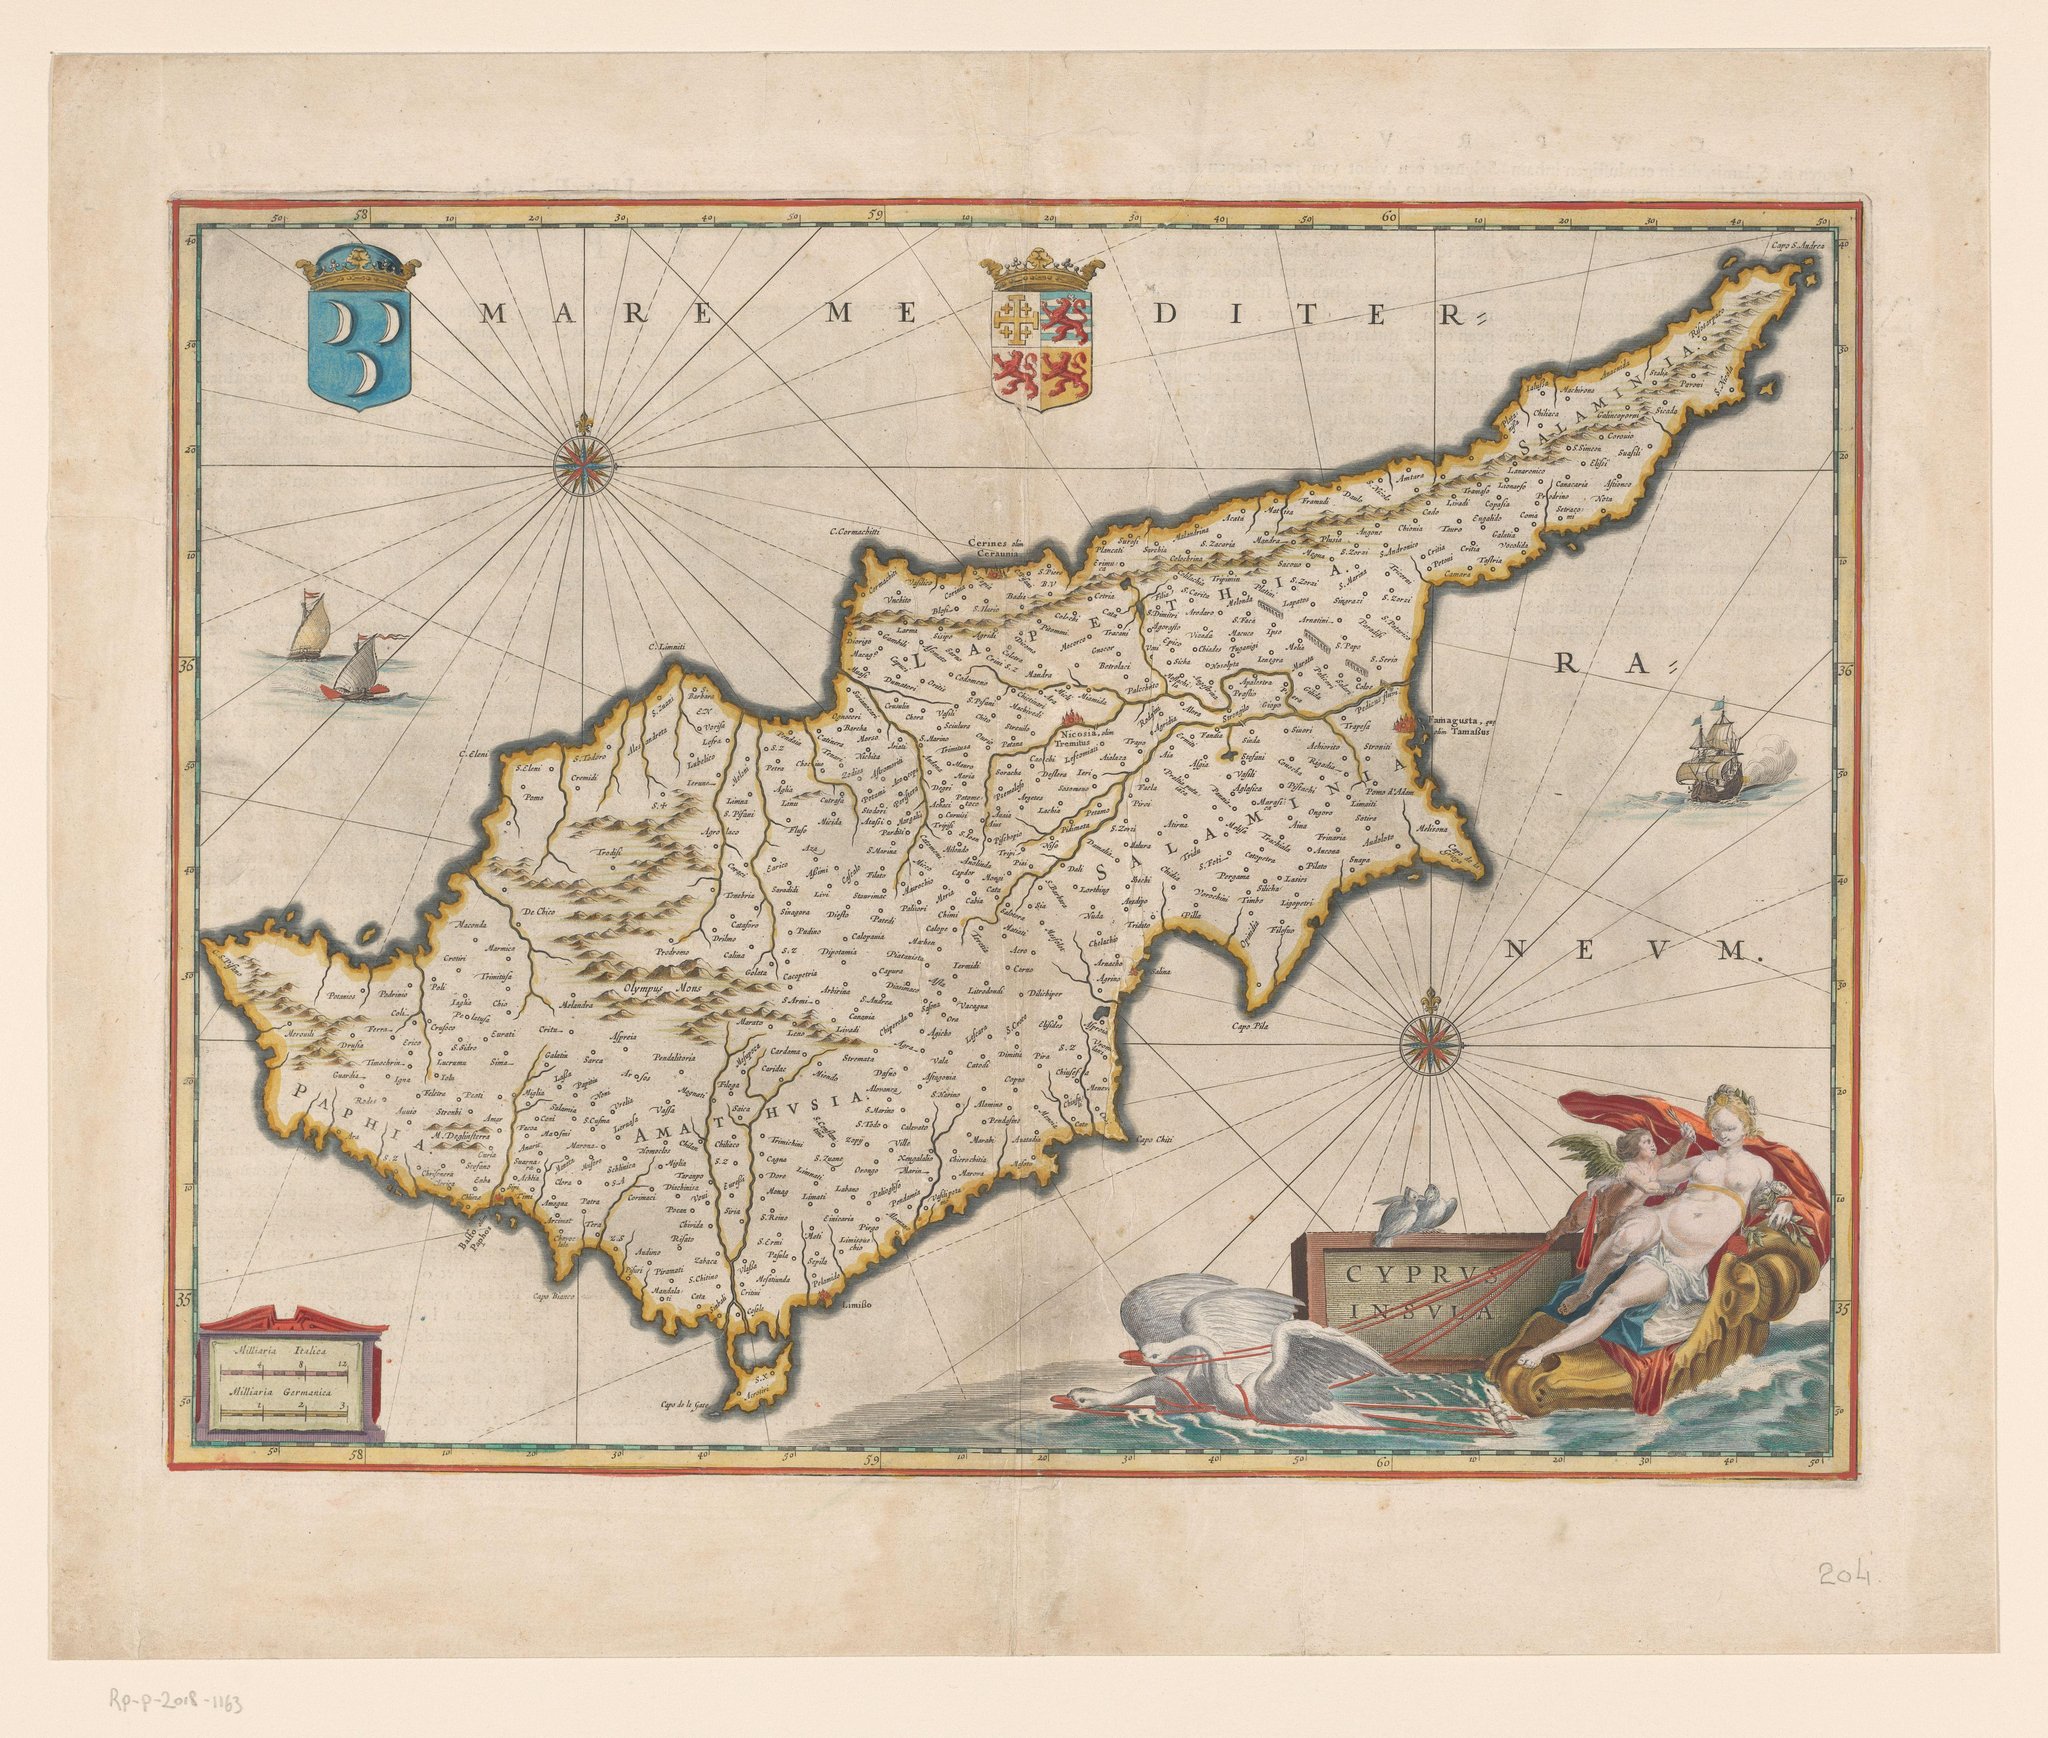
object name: print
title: Kaart van Cyprus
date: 1642-1648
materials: paper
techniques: engraving, hand coloring, letterpress printing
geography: amsterdam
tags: coat of arms (as symbol of the state, etc.) (+ city; municipal), attributes of venus, maps of separate countries or regions, (story of) venus (aphrodite)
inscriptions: collector's mark: Lugt 2228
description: Rechtsonder een voorstelling met Venus en Cupido op een wagen getrokken door twee zwanen. Met Nederlandse tekst in boekdruk op verso.